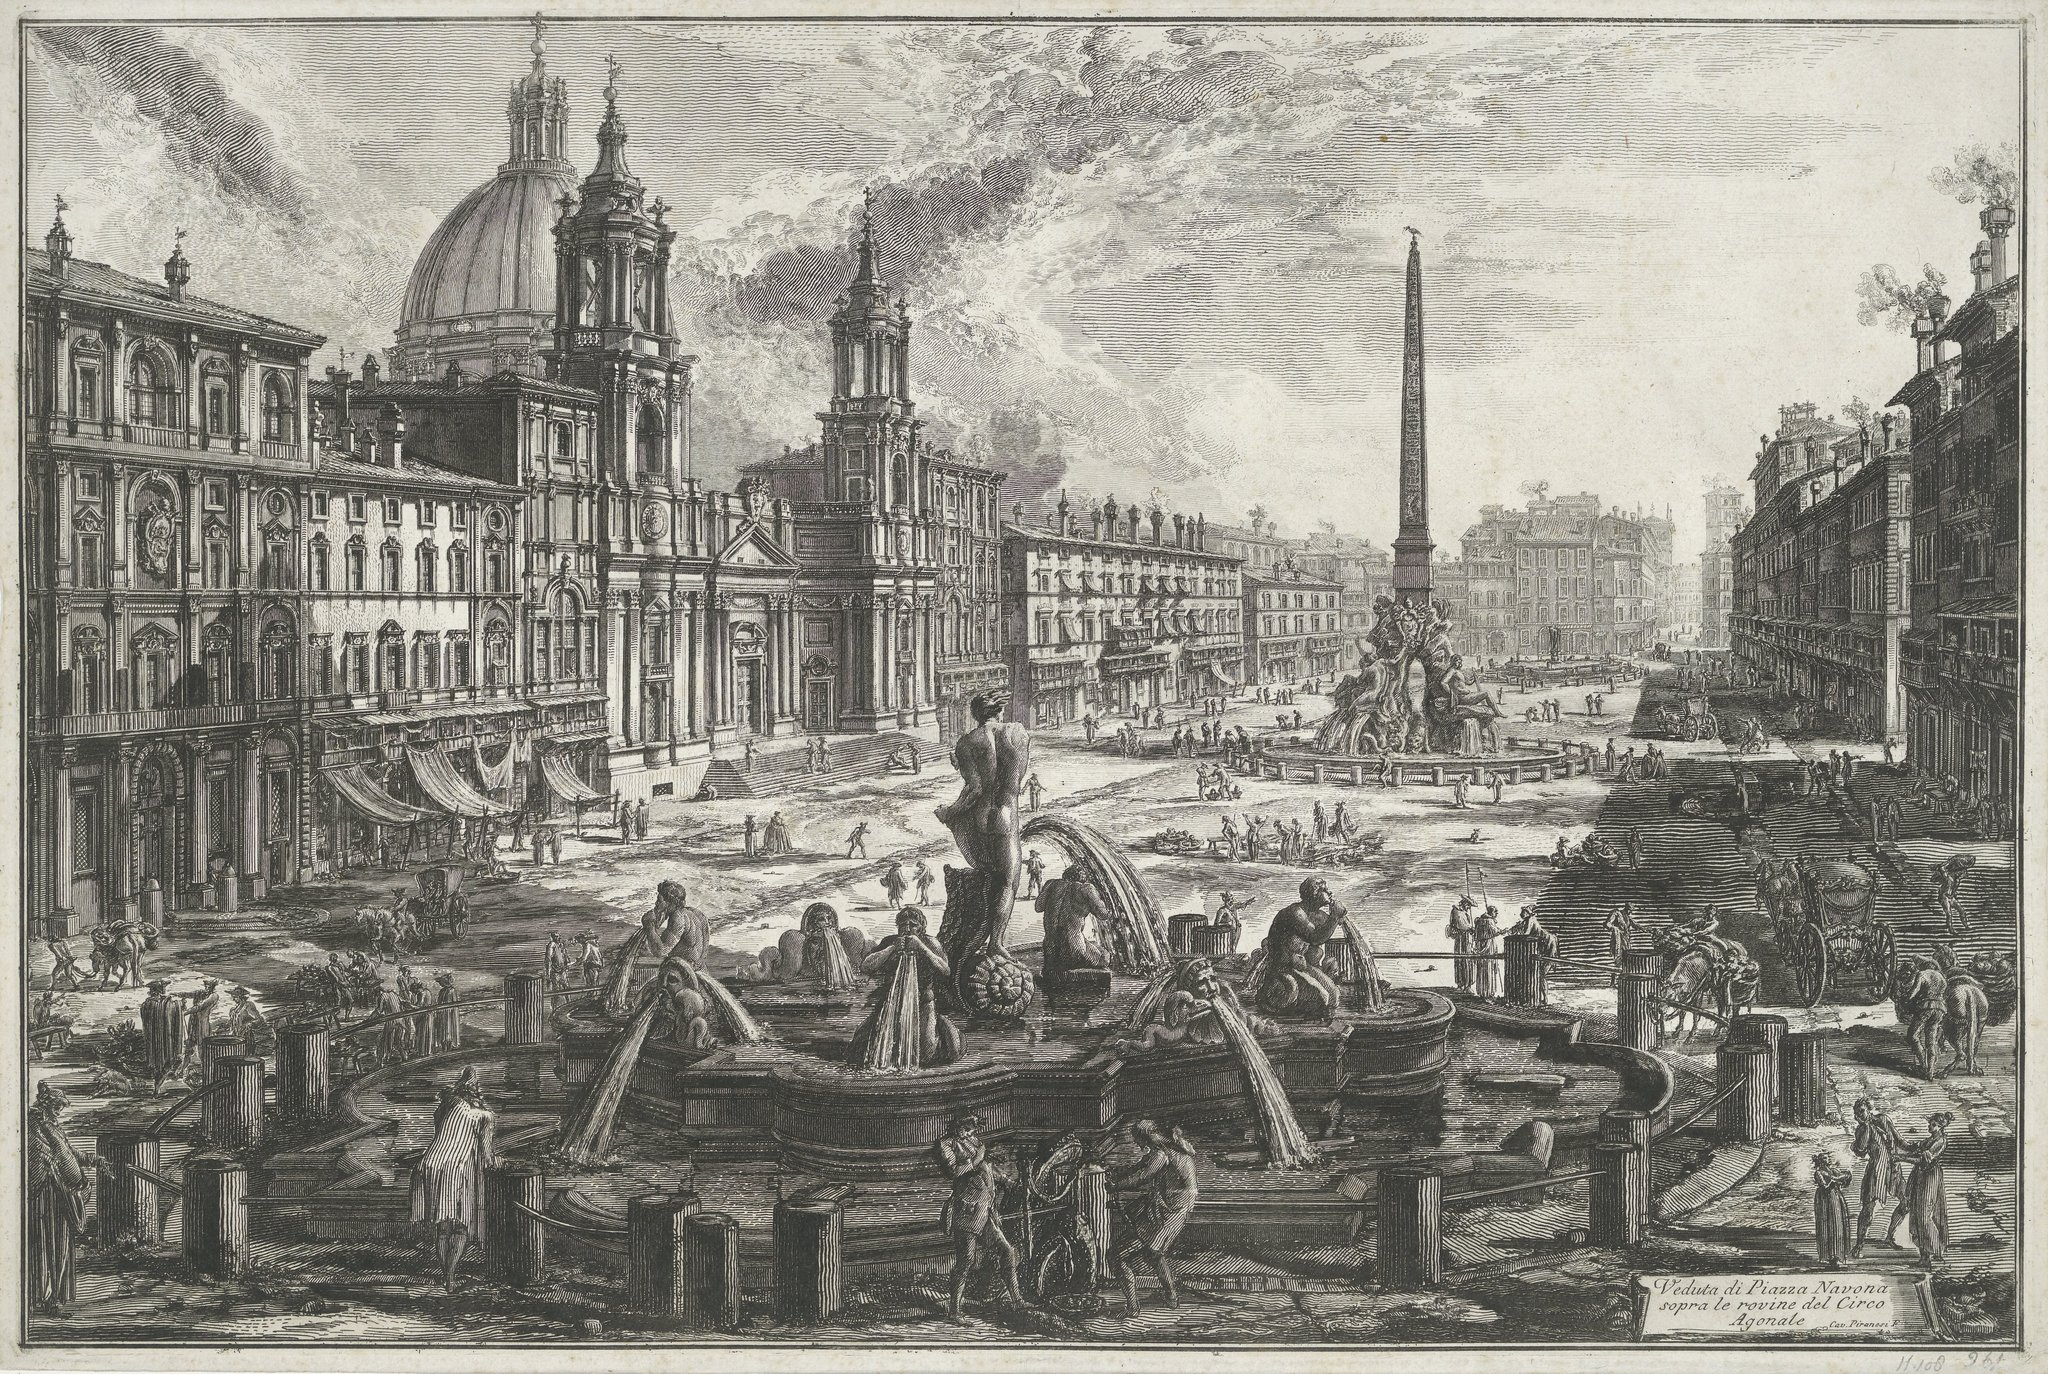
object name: print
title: Veduta di Piazza Navona sopra le rovine del Circo Agonale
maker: giovanni battista piranesi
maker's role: designer, draughtsman, print maker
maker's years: 1720-1778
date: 1748-1778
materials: paper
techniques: etching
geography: rome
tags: square, place, circus, etc., church (exterior), parts of church exterior and annexes: façade, ornamental fountain, rome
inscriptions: collector's mark: Lugt 2228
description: Deze prent maakt deel uit van de serie 'Vedute di Roma'. Piranesi werkte aan deze 135 platen tellende serie tussen 1748 en zijn dood in 1778. Francesco Piranesi voegde later nog twee prenten toe aan de reeks van zijn vader.